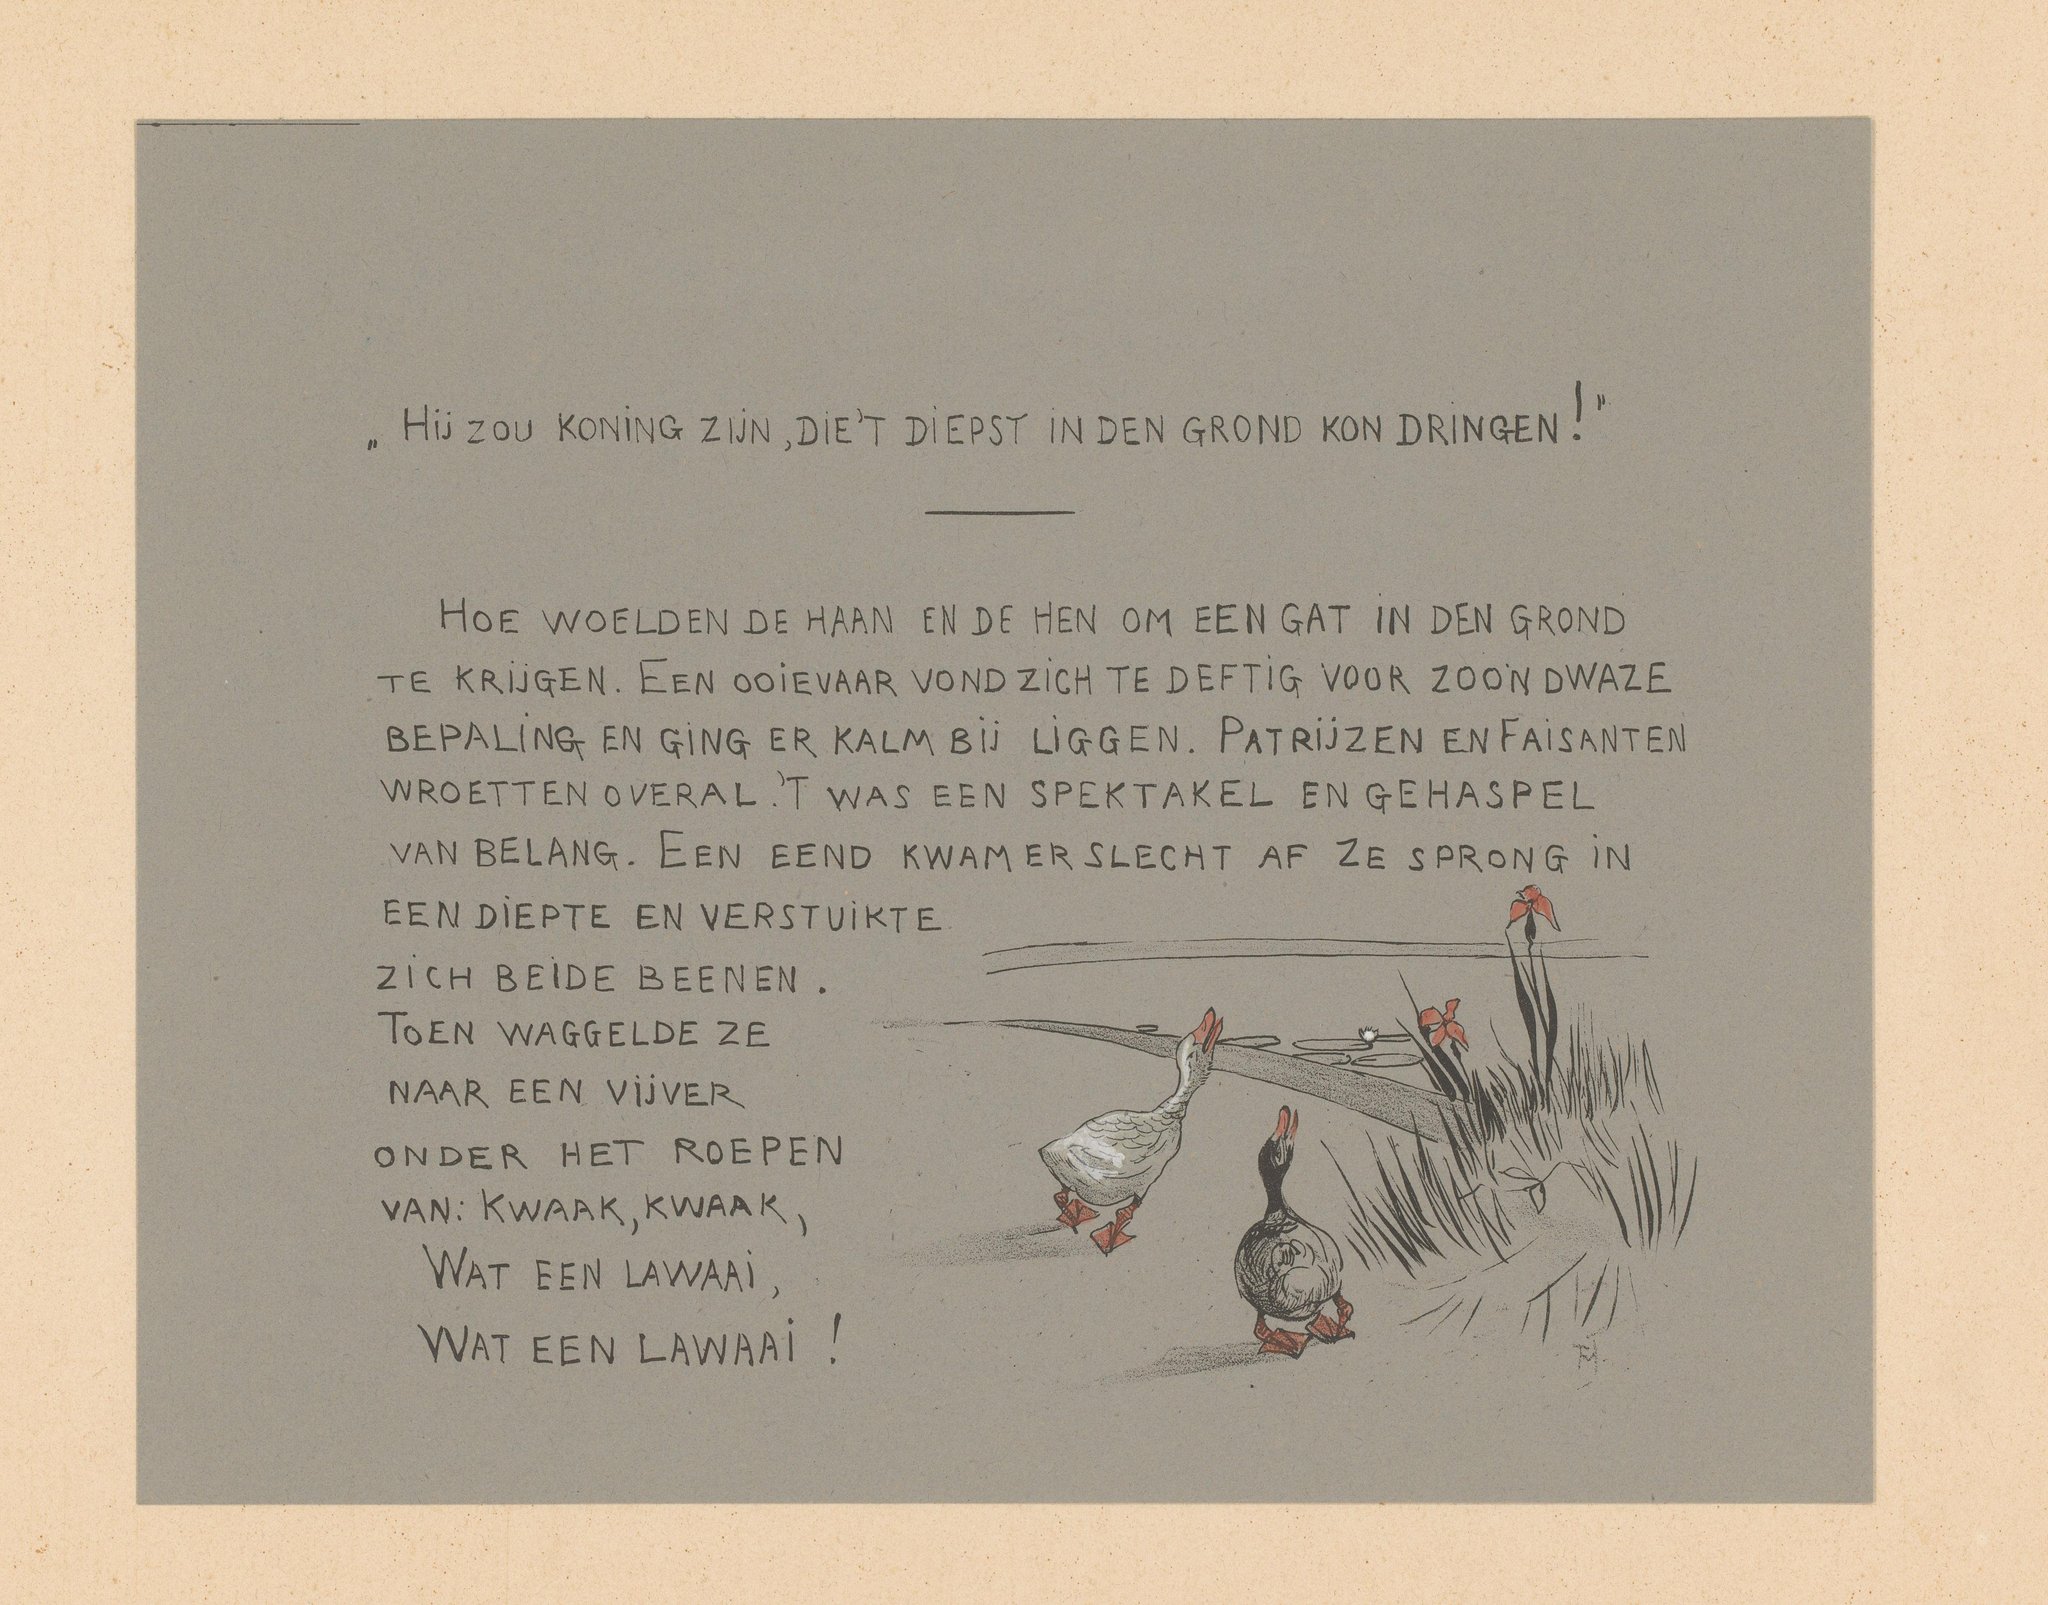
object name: print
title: Hoe de vogels aan een koning kwamen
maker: theo van hoytema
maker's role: draughtsman, painter, print maker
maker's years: 1863-1917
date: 1892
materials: paper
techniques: hand coloring, lithograph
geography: the hague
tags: water-birds: goose, water-birds: duck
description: Zowel tekst als afbeelding zijn gelithografeerd.